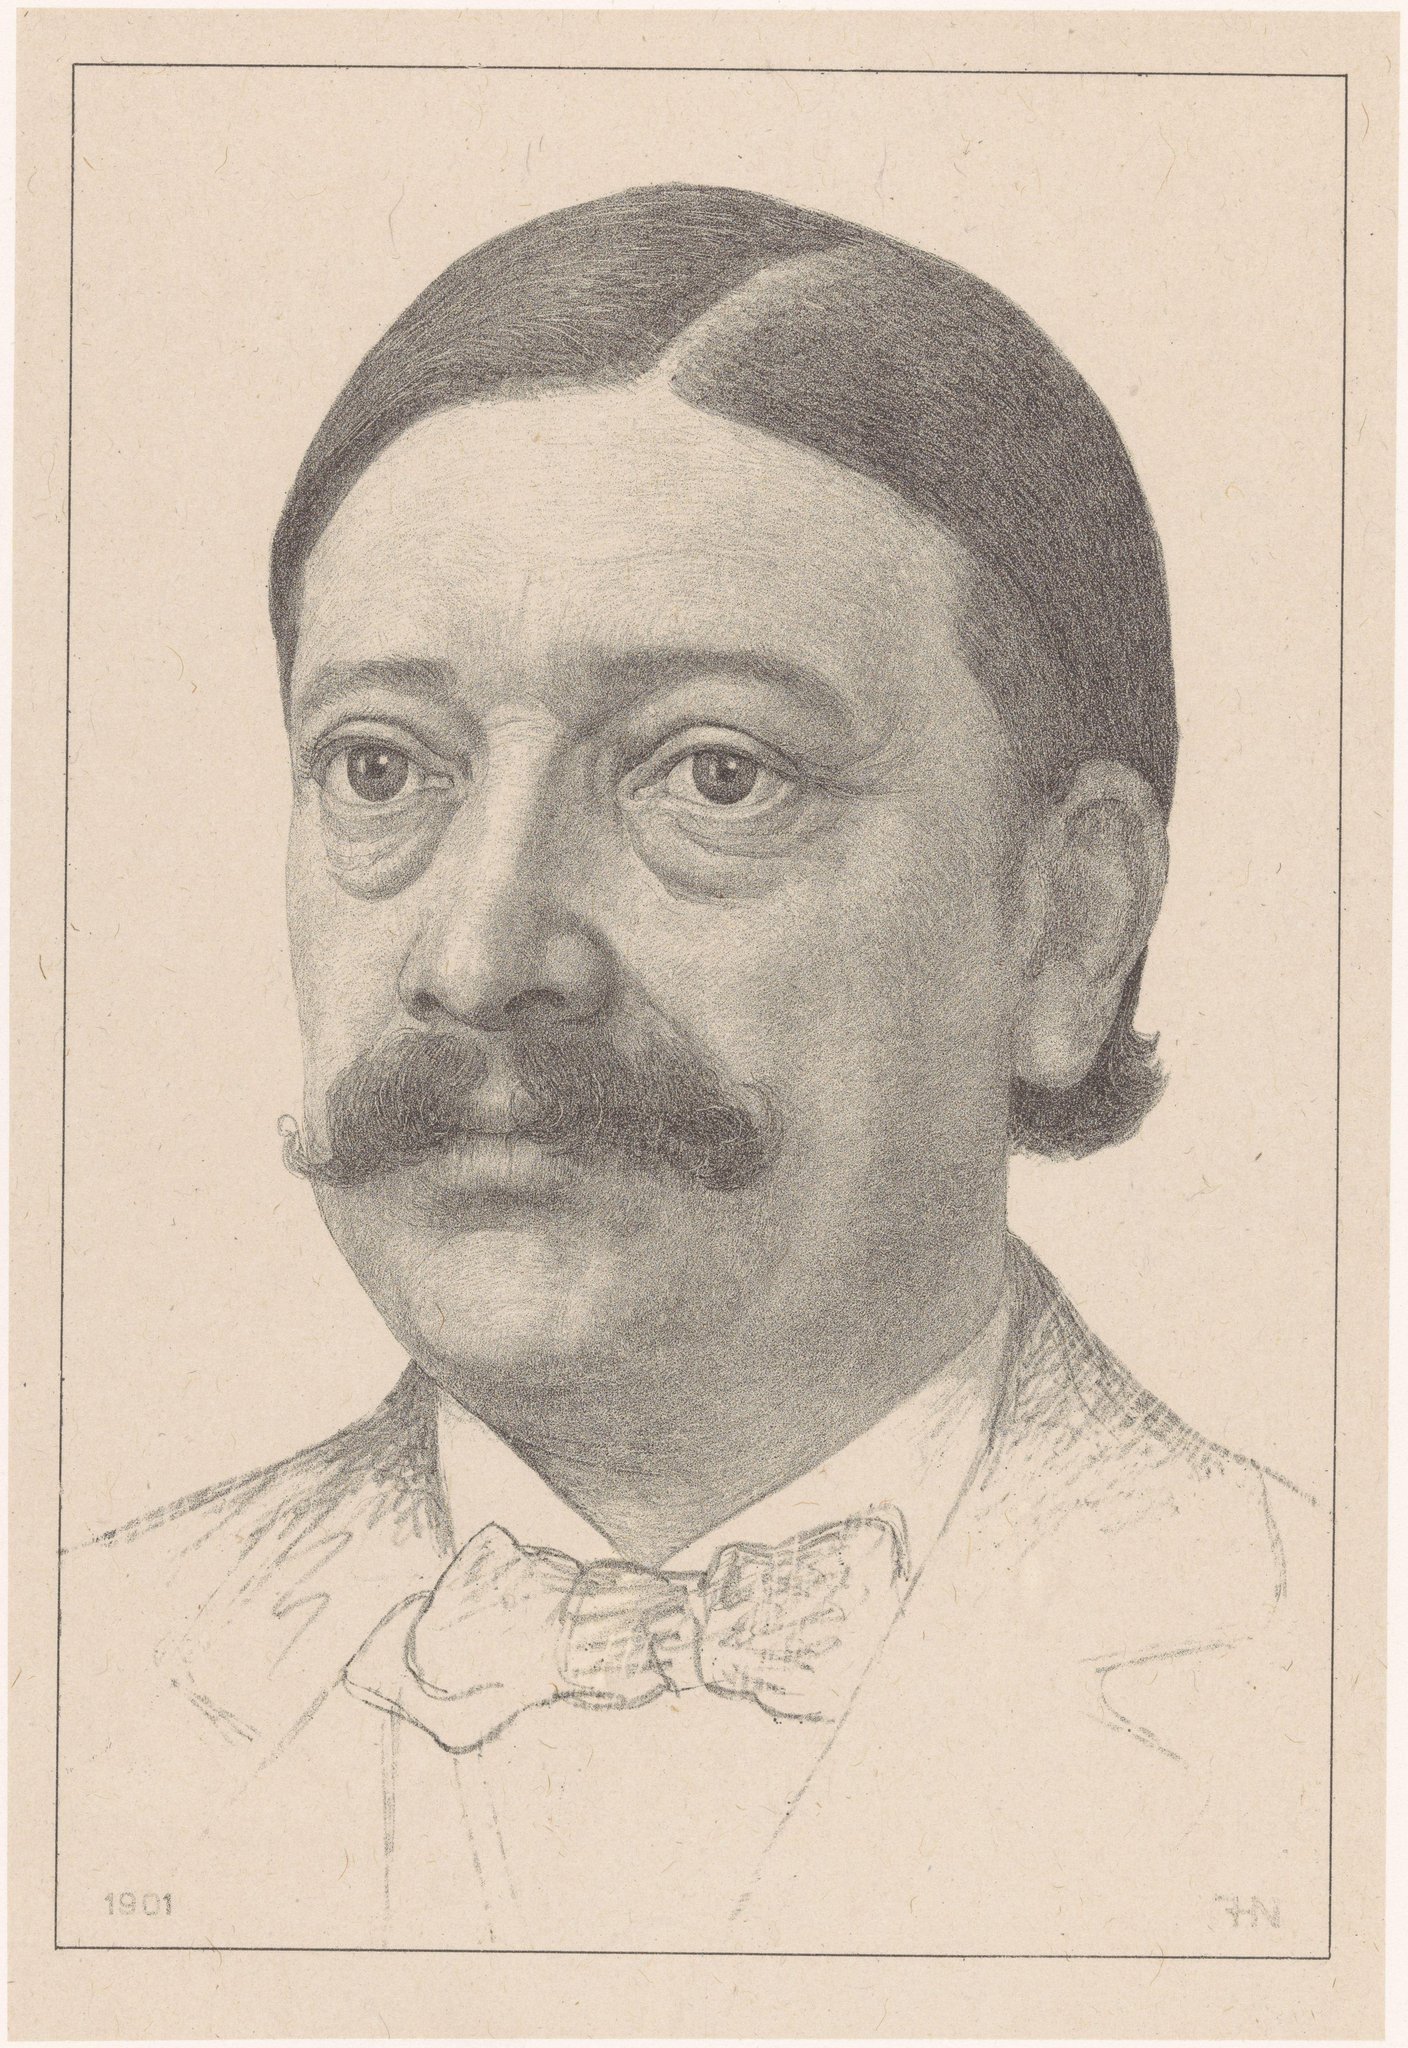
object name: print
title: Portret van Pieter Klazes Pel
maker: ferdinand hart nibbrig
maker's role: draughtsman, painter, print maker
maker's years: 1866-1915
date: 1901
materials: paper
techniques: lithograph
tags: amsterdam, moustache, historical persons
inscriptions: collector's mark: Lugt 2228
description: Een portret van hoogleraar geneeskunde Pieter Klazes Pel, met snor.